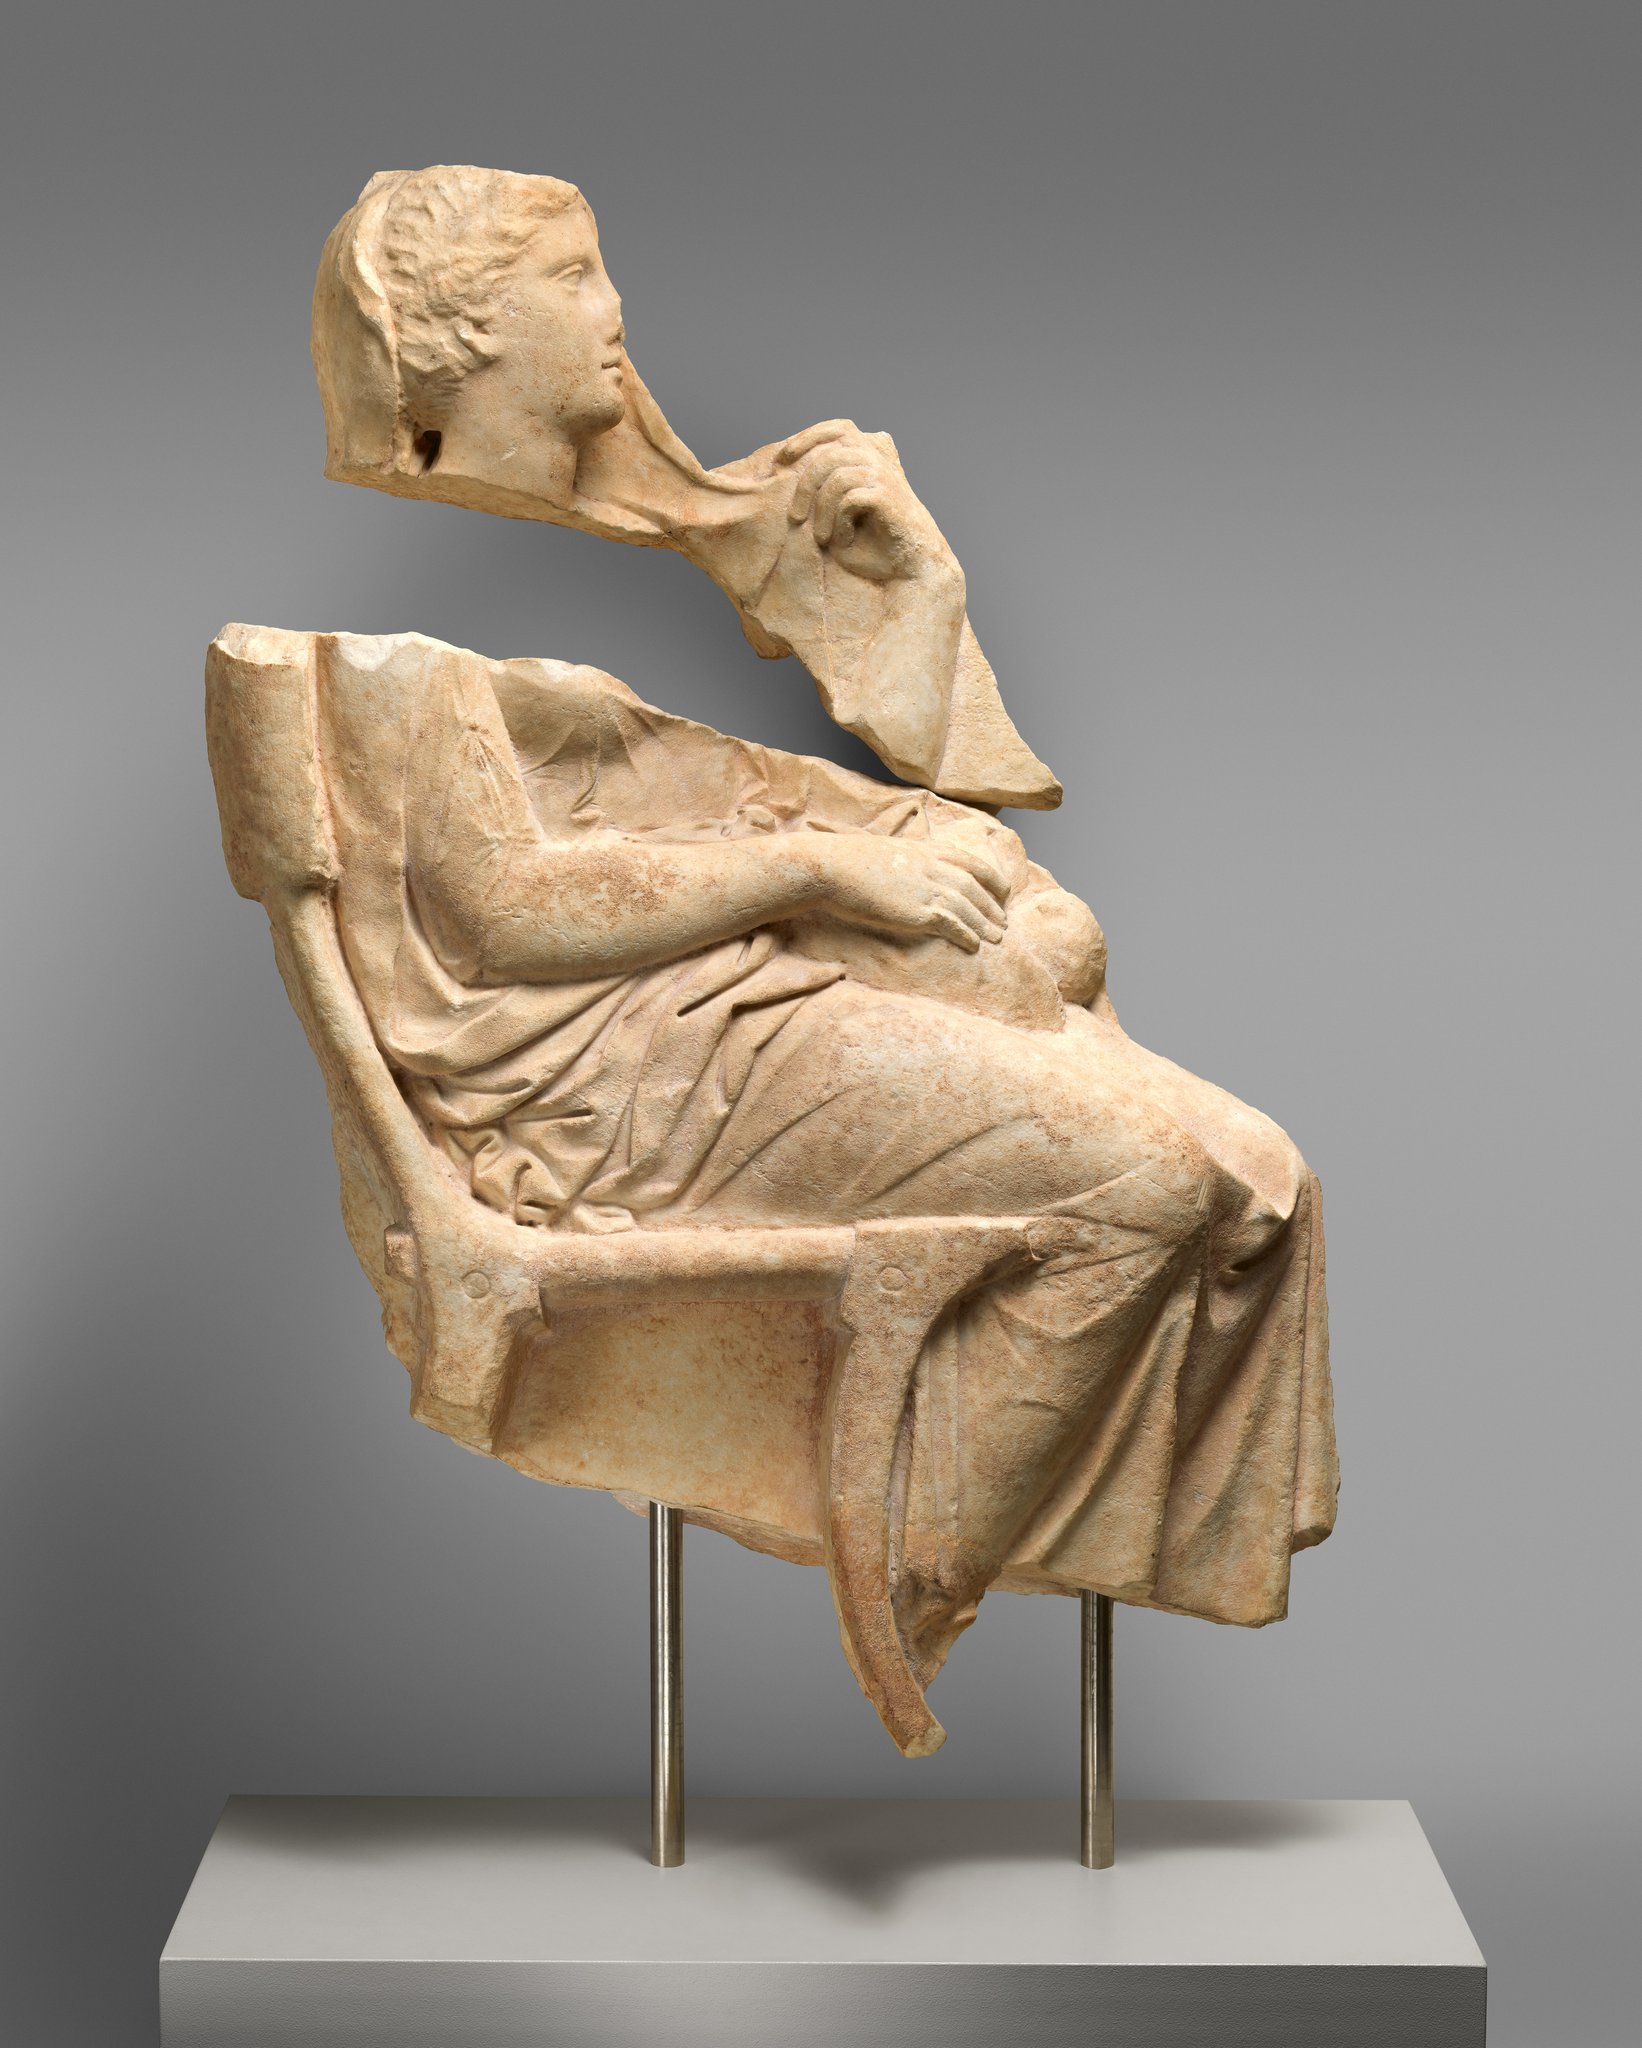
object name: grave relief, fragment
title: Fragments of the marble stele (grave marker) of a woman holding a baby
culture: greek, attic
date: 400-375 BCE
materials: marble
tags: infants,women